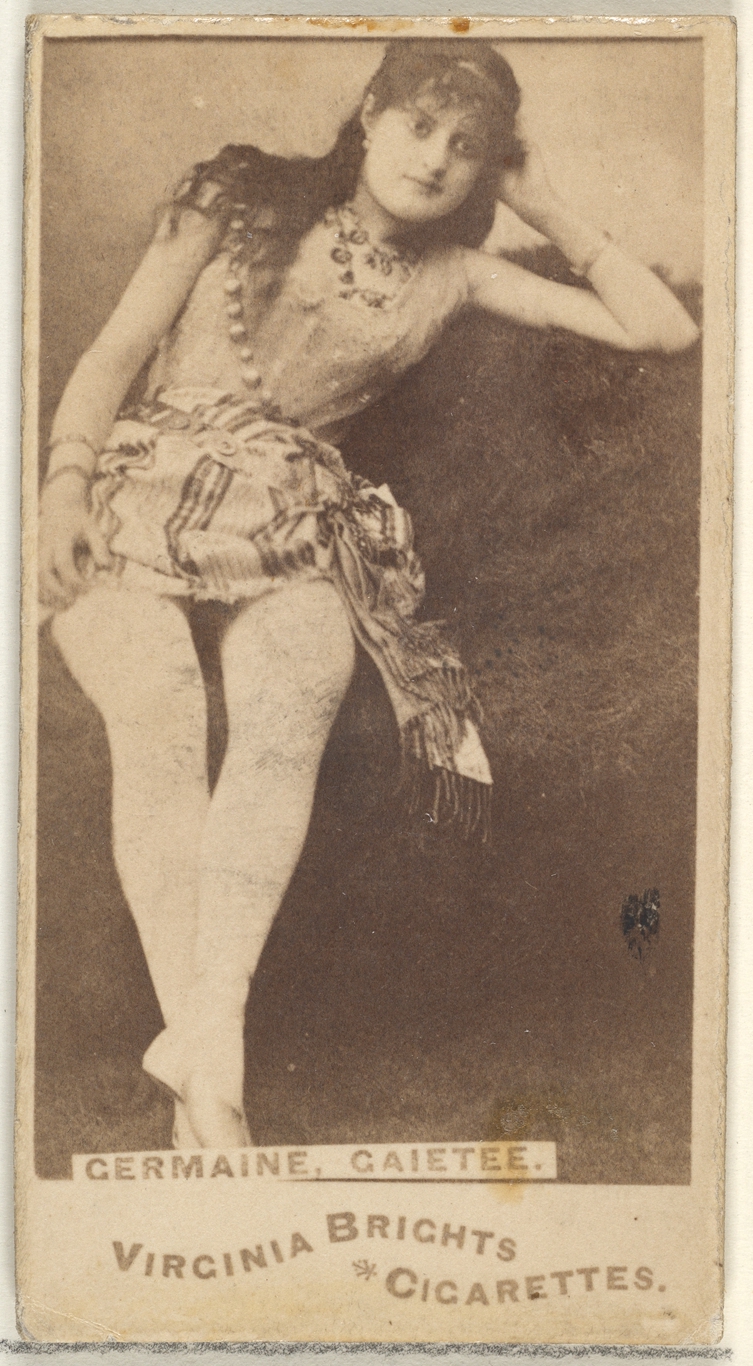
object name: photograph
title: Germaine, Gaietee, from the Actors and Actresses series (N45, Type 1) for Virginia Brights Cigarettes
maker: allen & ginter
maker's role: publisher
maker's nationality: american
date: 1888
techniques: albumen silver print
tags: portraits,women,actresses